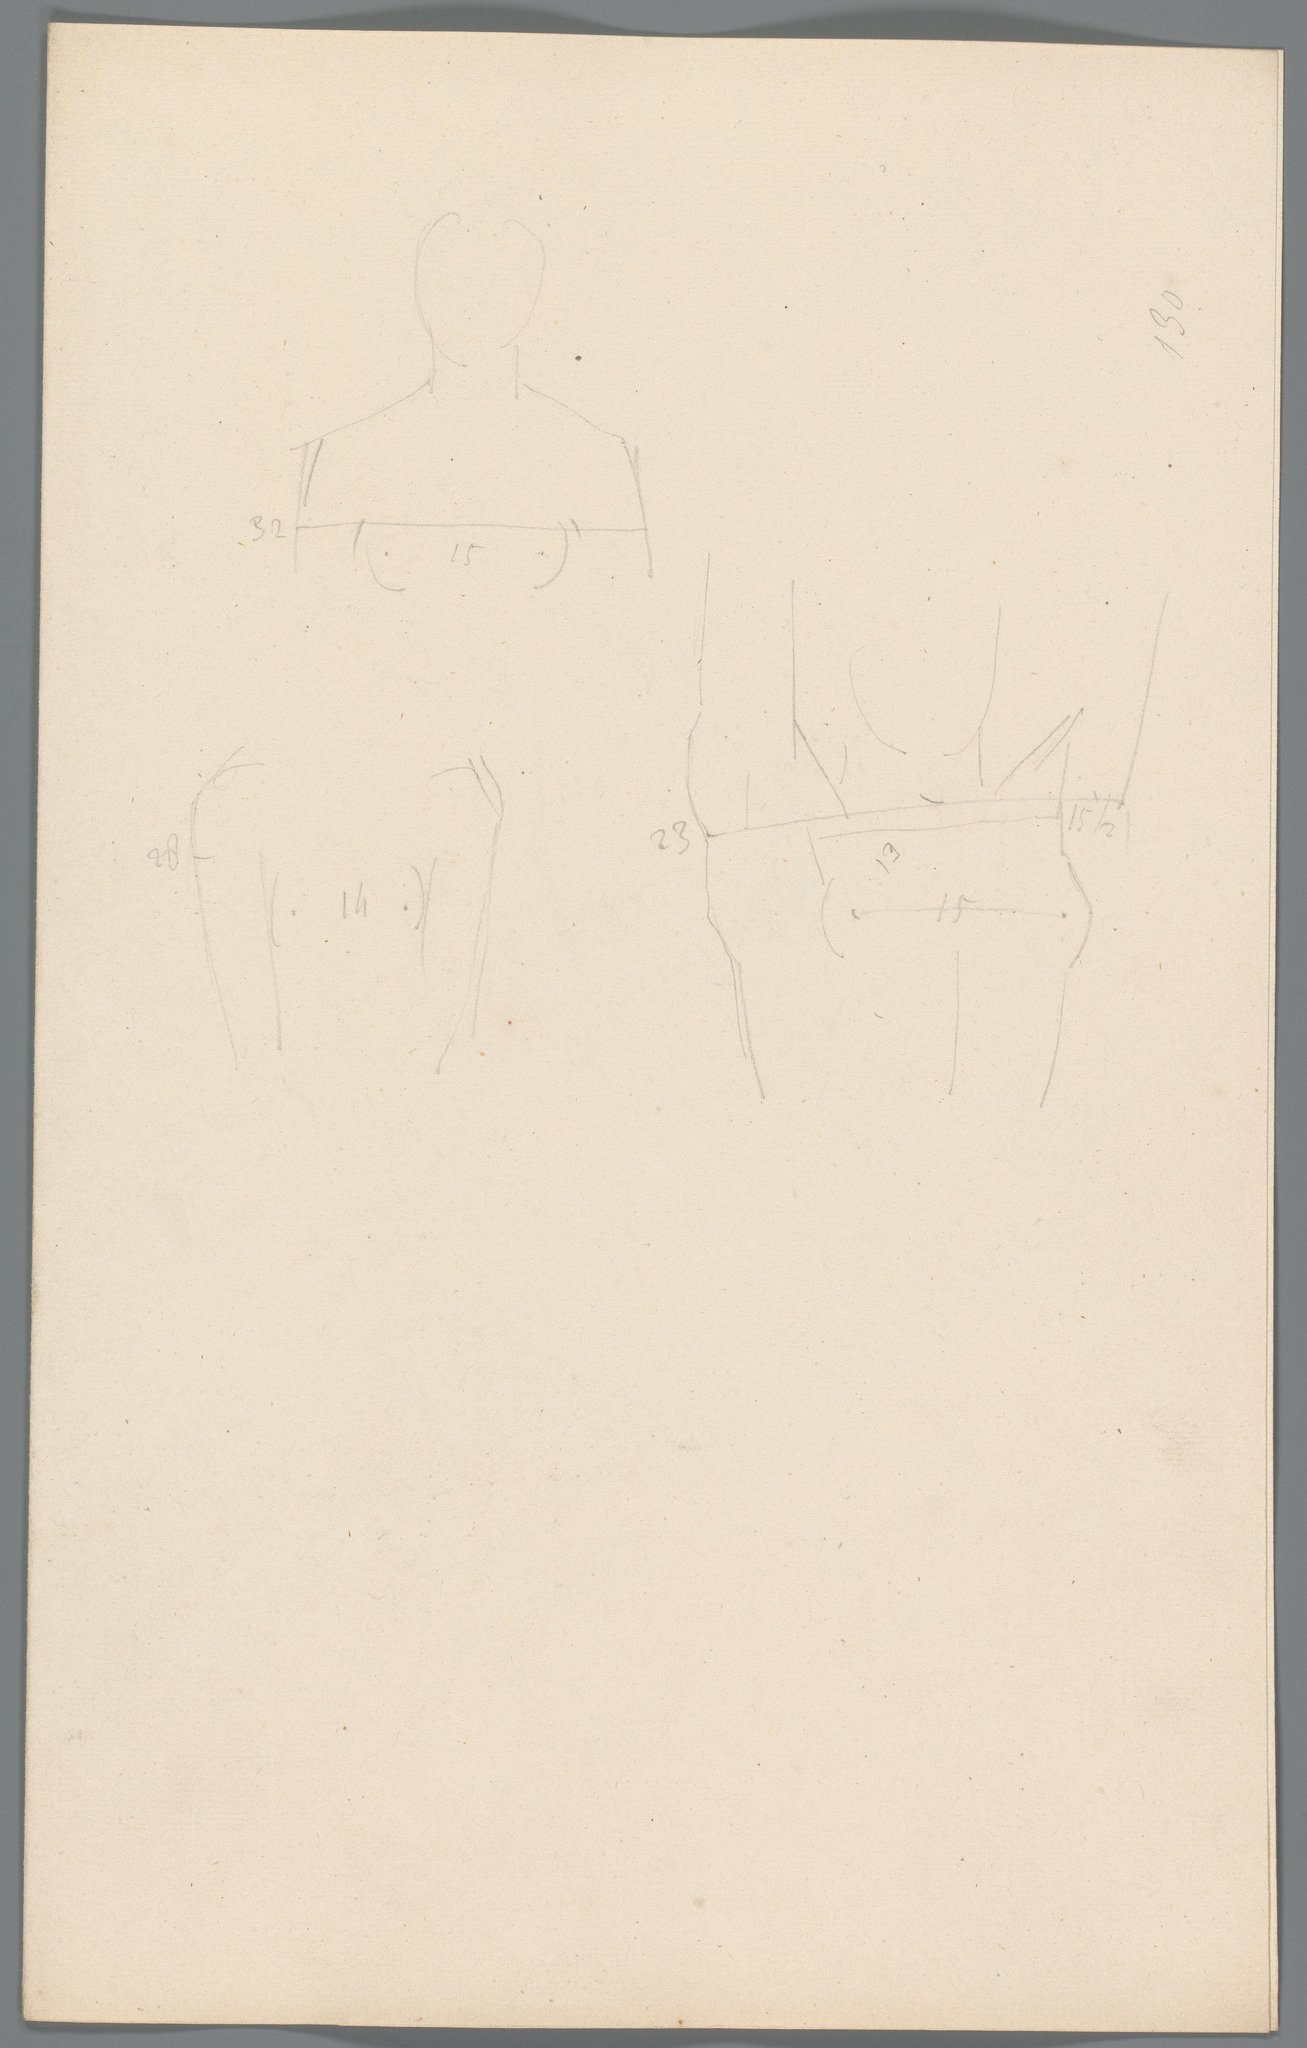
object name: drawing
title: Figuurstudies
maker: jacobus everhardus josephus van den berg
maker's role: draughtsman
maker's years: 1802-1861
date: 1812-1861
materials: paper, pencil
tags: the (nude) human figure; 'corpo humano' (ripa) - aa - female human figure